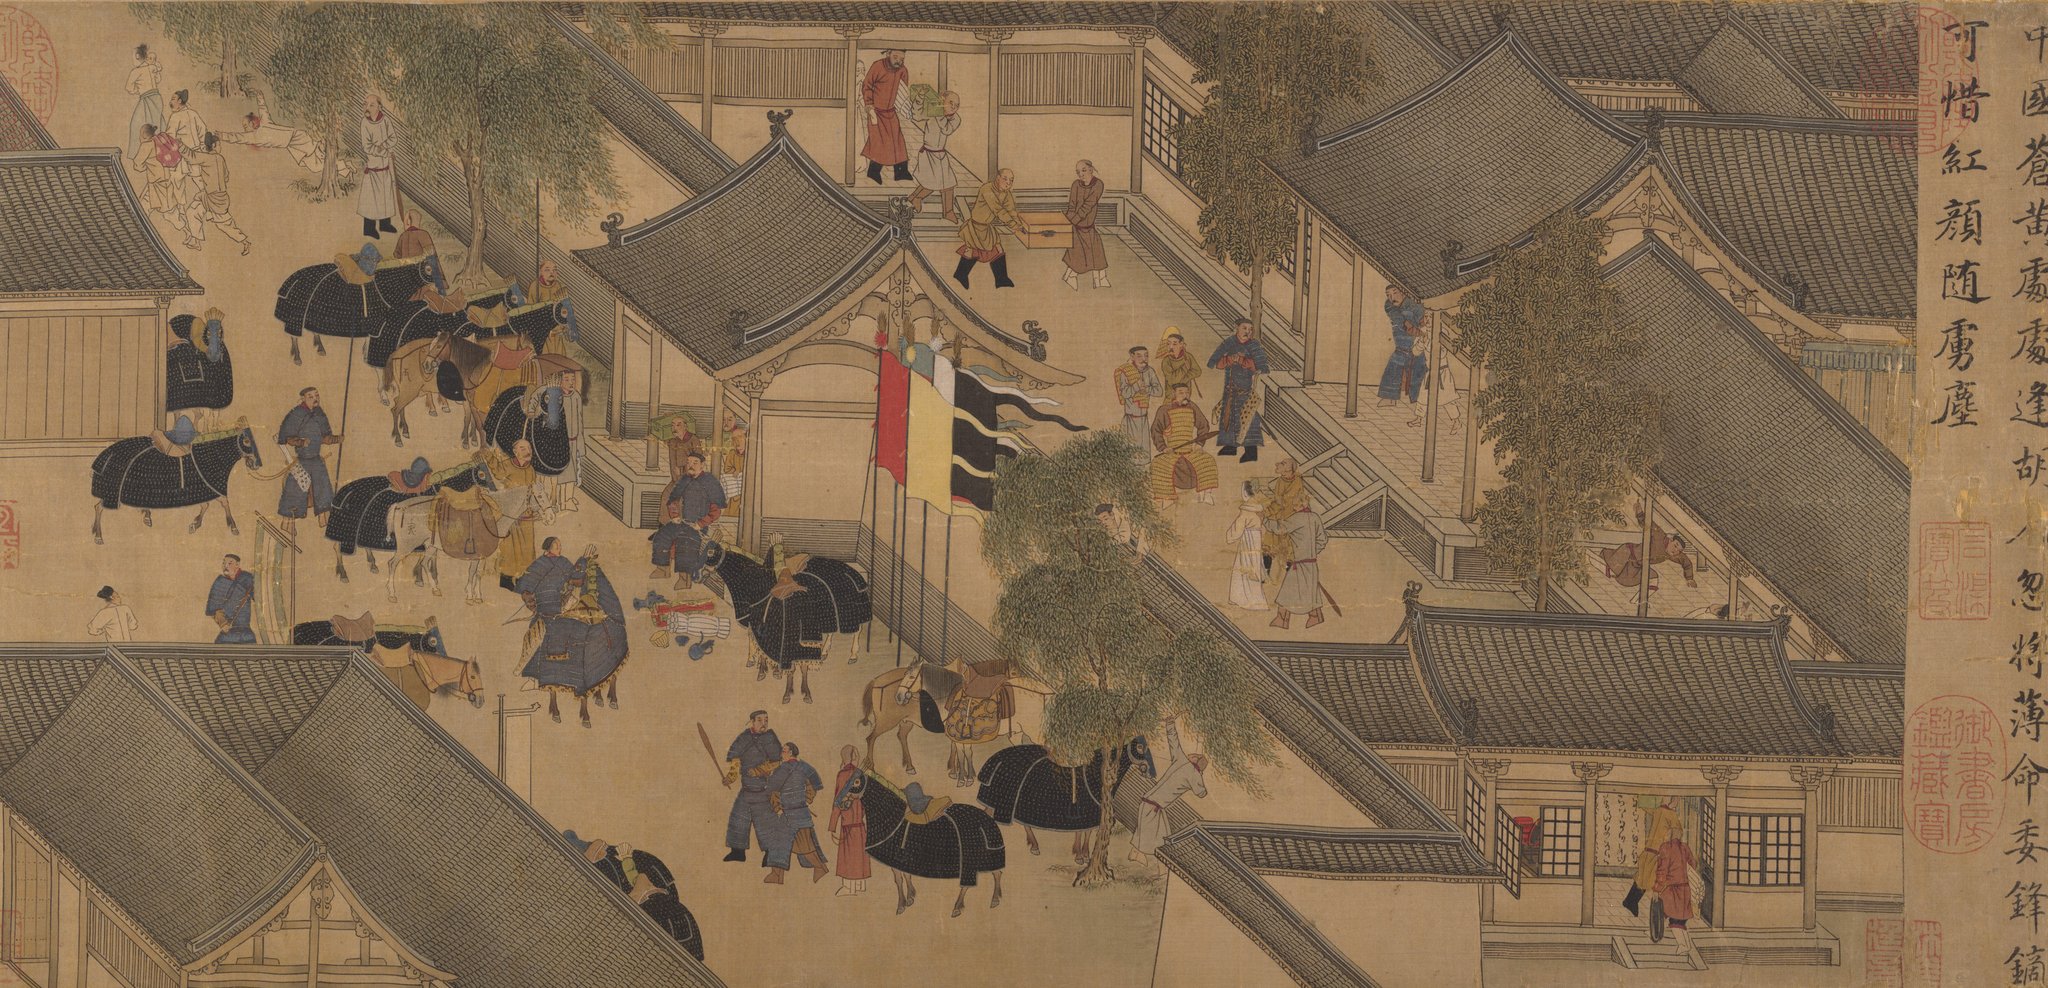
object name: handscroll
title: Eighteen Songs of a Nomad Flute: The Story of Lady Wenji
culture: chinese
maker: unidentified artist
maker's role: artist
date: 1401-1433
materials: gold, ink, silk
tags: tents,men,women,horses